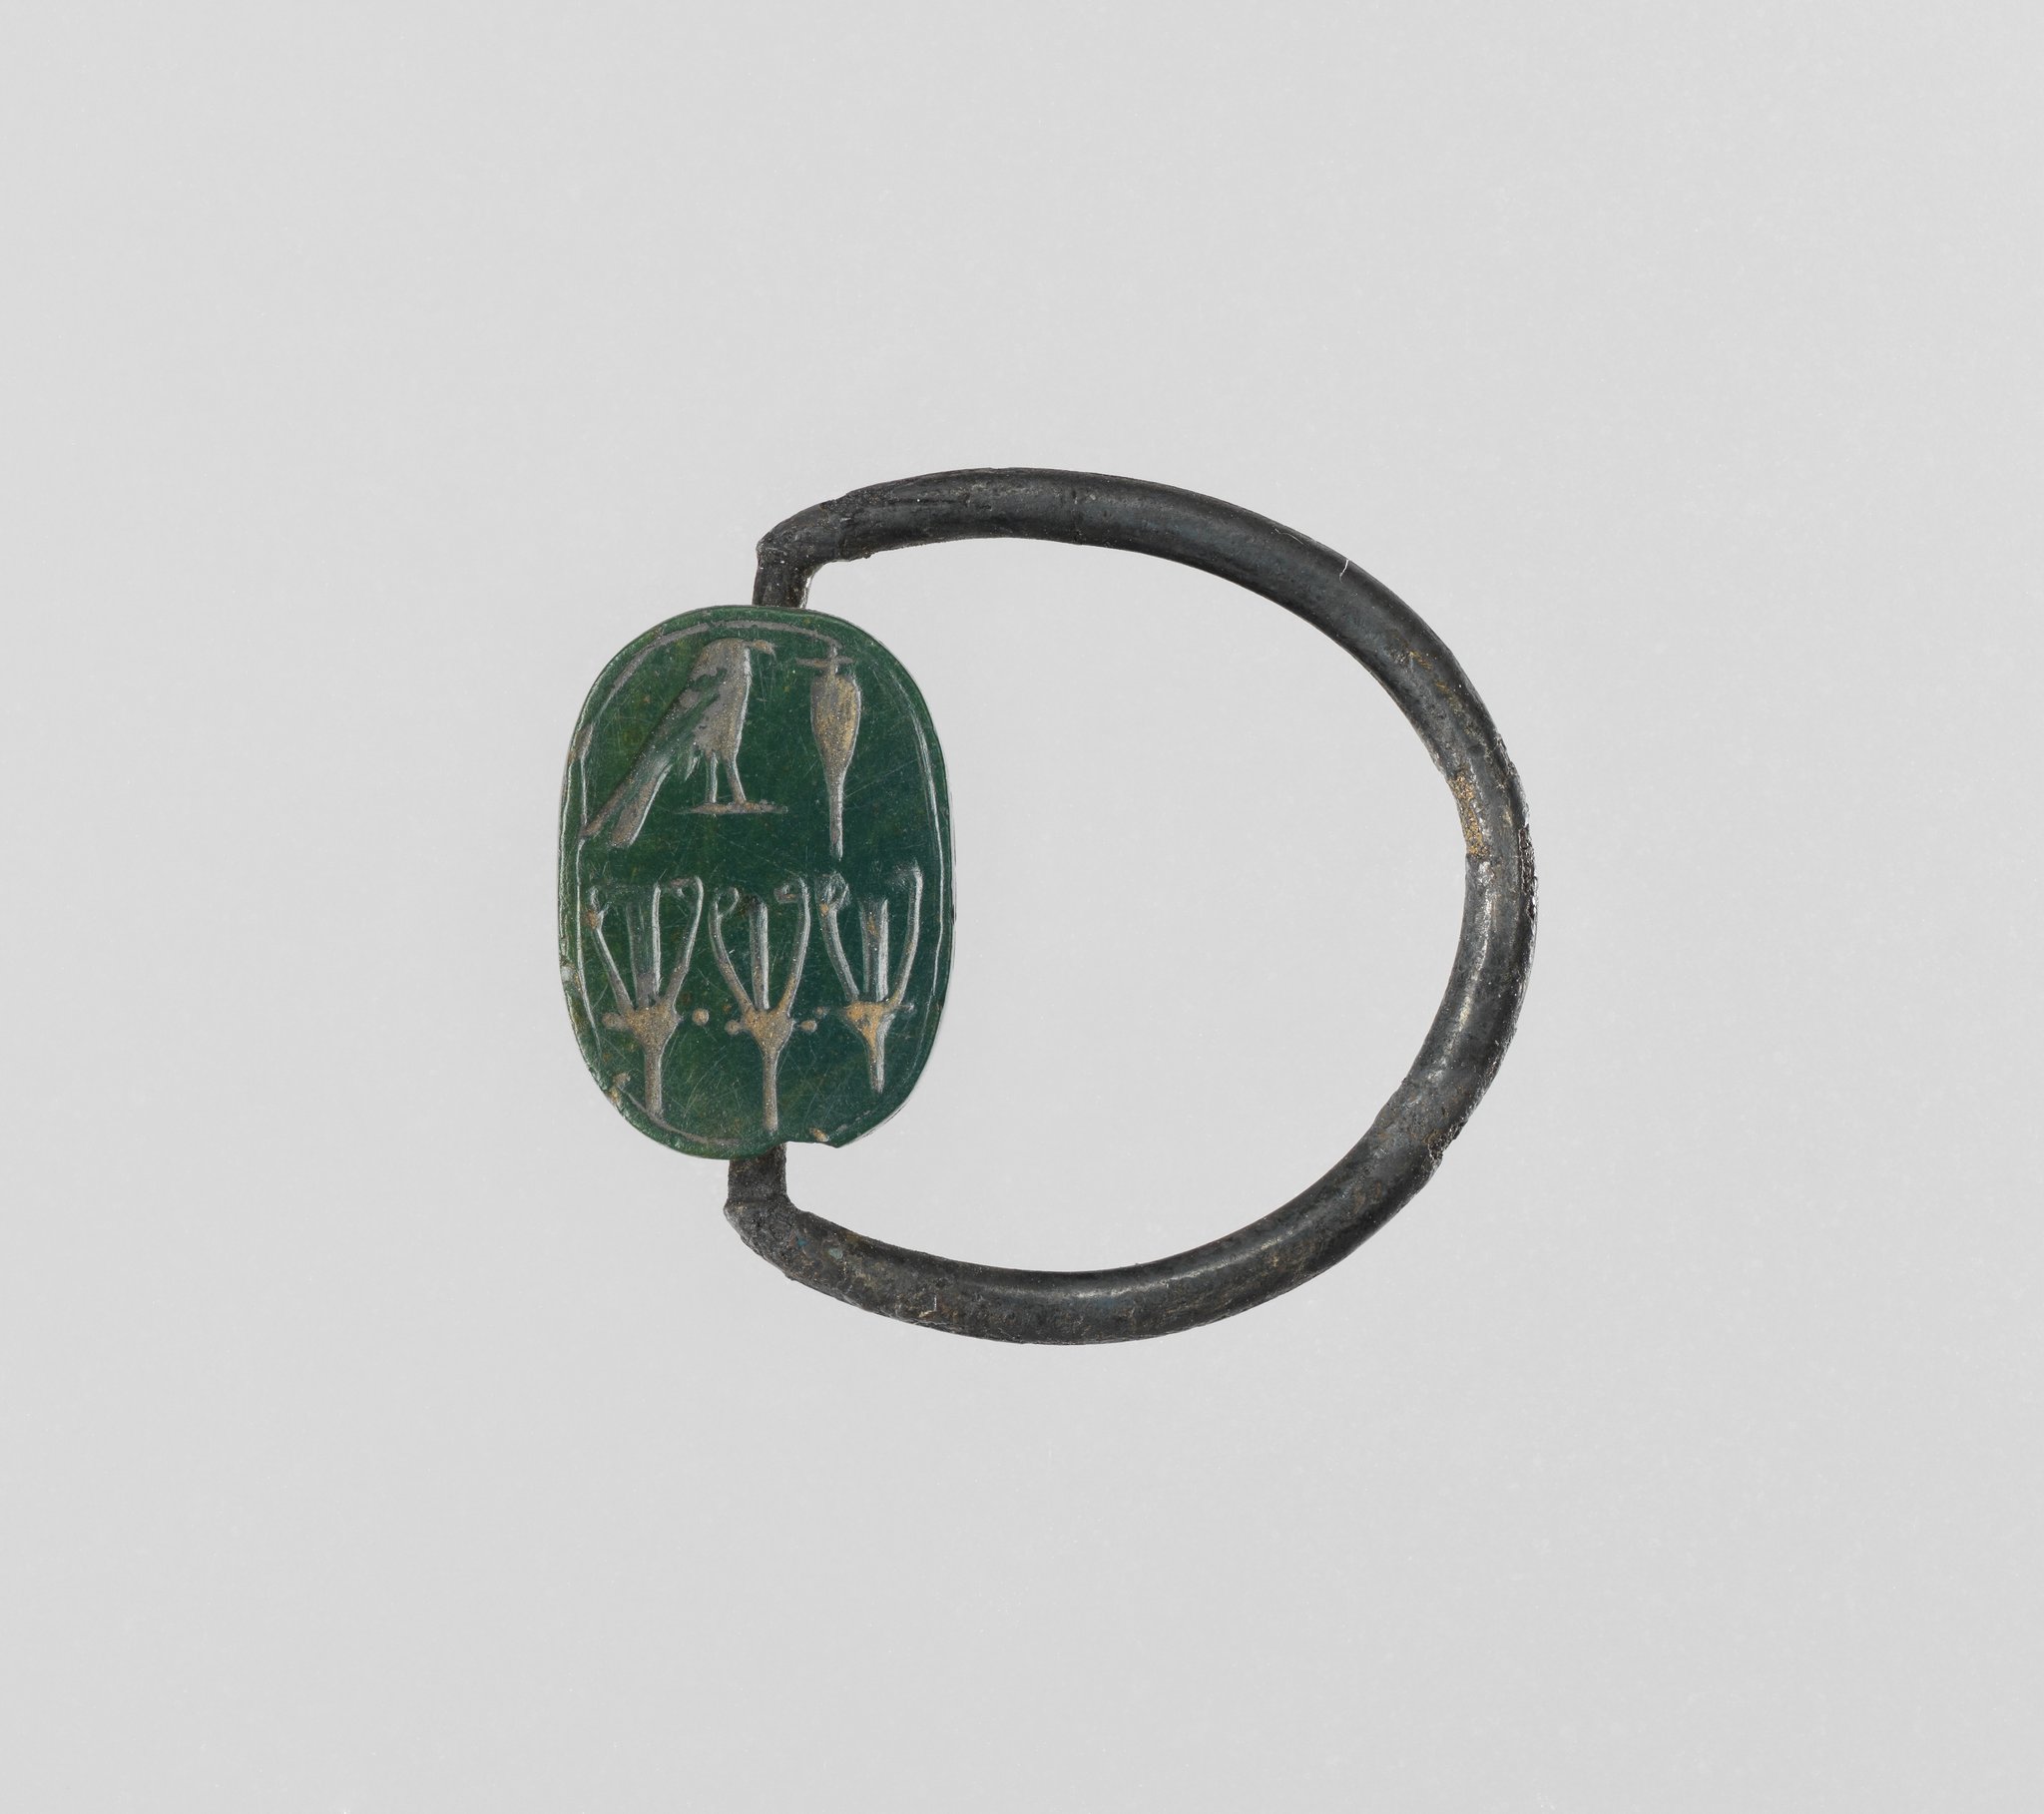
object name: ring, signet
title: Signet ring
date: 1070-712 BCE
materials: jasper, silver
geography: egypt